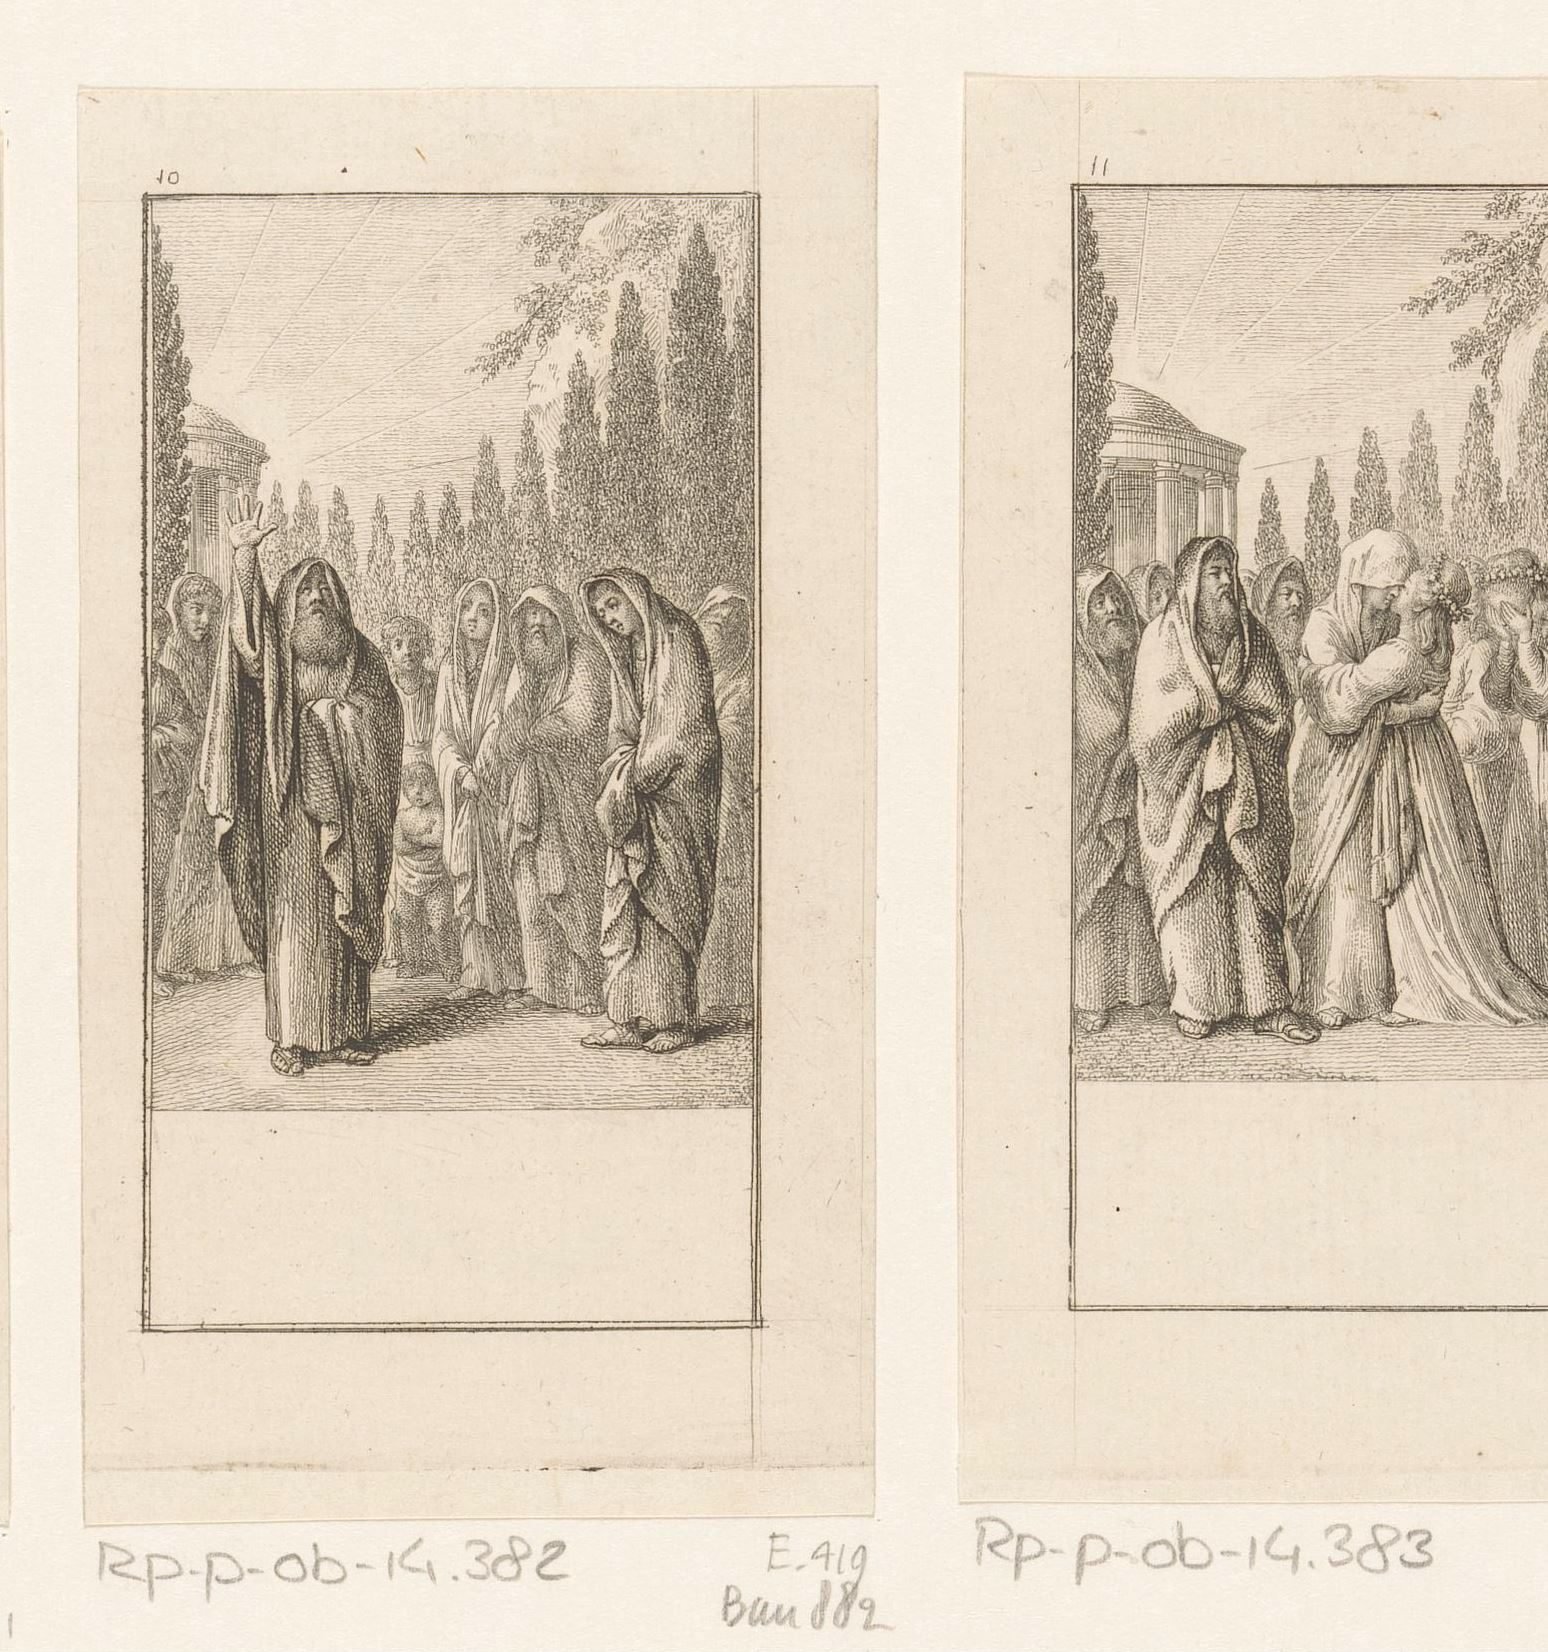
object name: print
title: Oude brahmaan begint het offerritueel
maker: daniel nikolaus chodowiecki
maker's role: draughtsman, print maker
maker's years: 1726-1801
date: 1782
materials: paper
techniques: etching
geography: berlin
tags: human sacrifice ~ non-christian religions, trees: cypress, literature, priest ~ non-christian religions, temple, shrine ~ non-christian religions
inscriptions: collector's mark: Lugt 2228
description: Vervaardigd voor Karl Martin Plümicke's 'Lanassa'. Latere staat gebruikt voor: Köningl. Grosbr. Genealogischer Kalender auf das 1783 Jahr. Lauenburg: J. G. Berenberg, 1782.